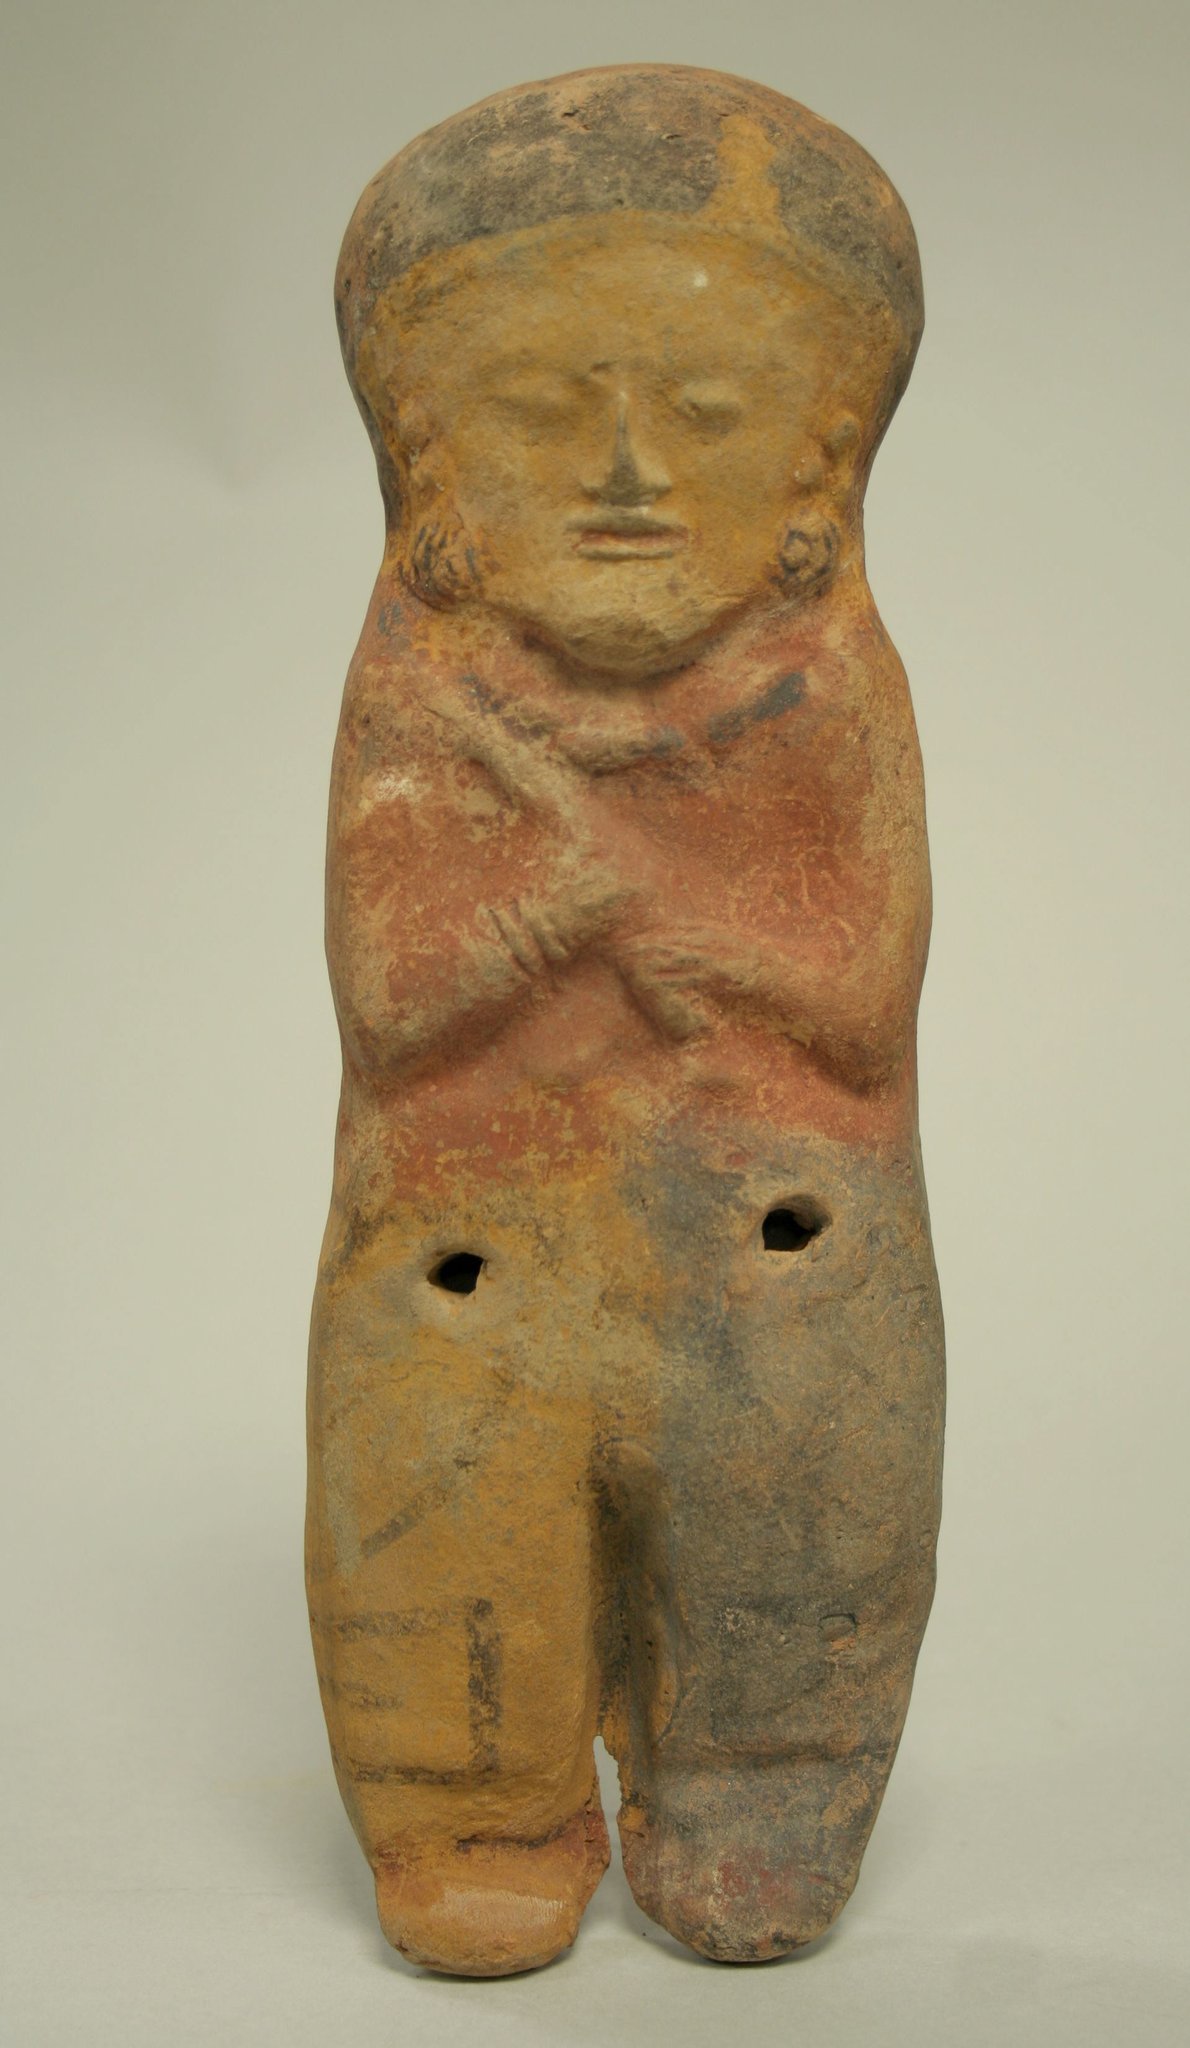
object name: whistle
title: Ceramic Whistle in the Form of a Standing Figure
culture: bahian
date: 500 BCE-400 CE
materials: ceramic, pigment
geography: ecuador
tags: musical instruments,women